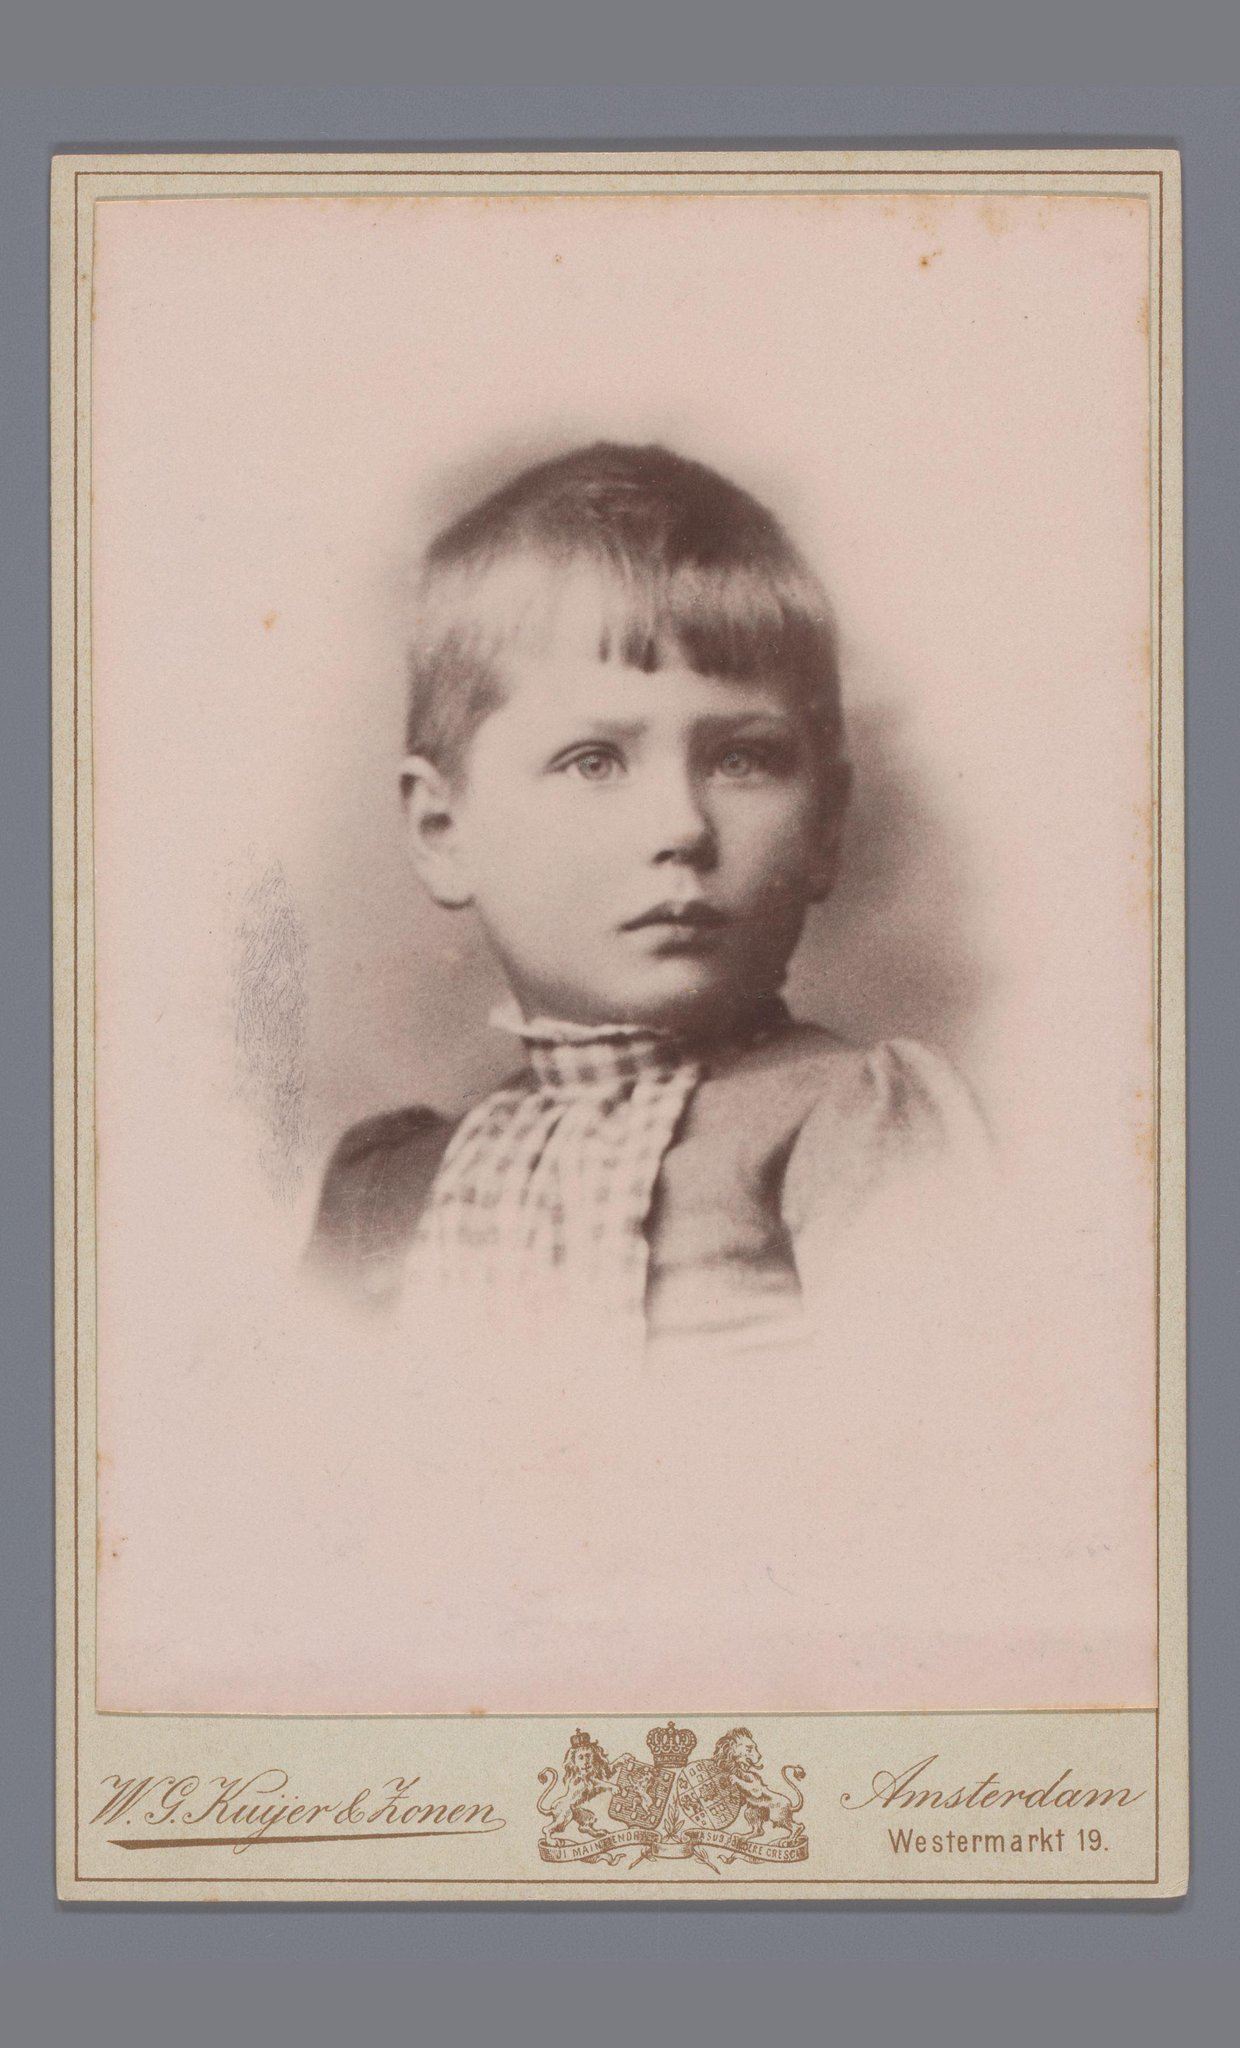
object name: photograph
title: Portret van Christina Maria Lucie Langhout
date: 1885-1906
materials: cardboard, photographic support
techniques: collodion silver print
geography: amsterdam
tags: historical persons, amsterdam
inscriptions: workshop stamp: ‘W.G. Kuijer & Zonen/ Hofphotographen/ Amsterdam, Westermarkt 19’, name: ‘Lucie Langhout’